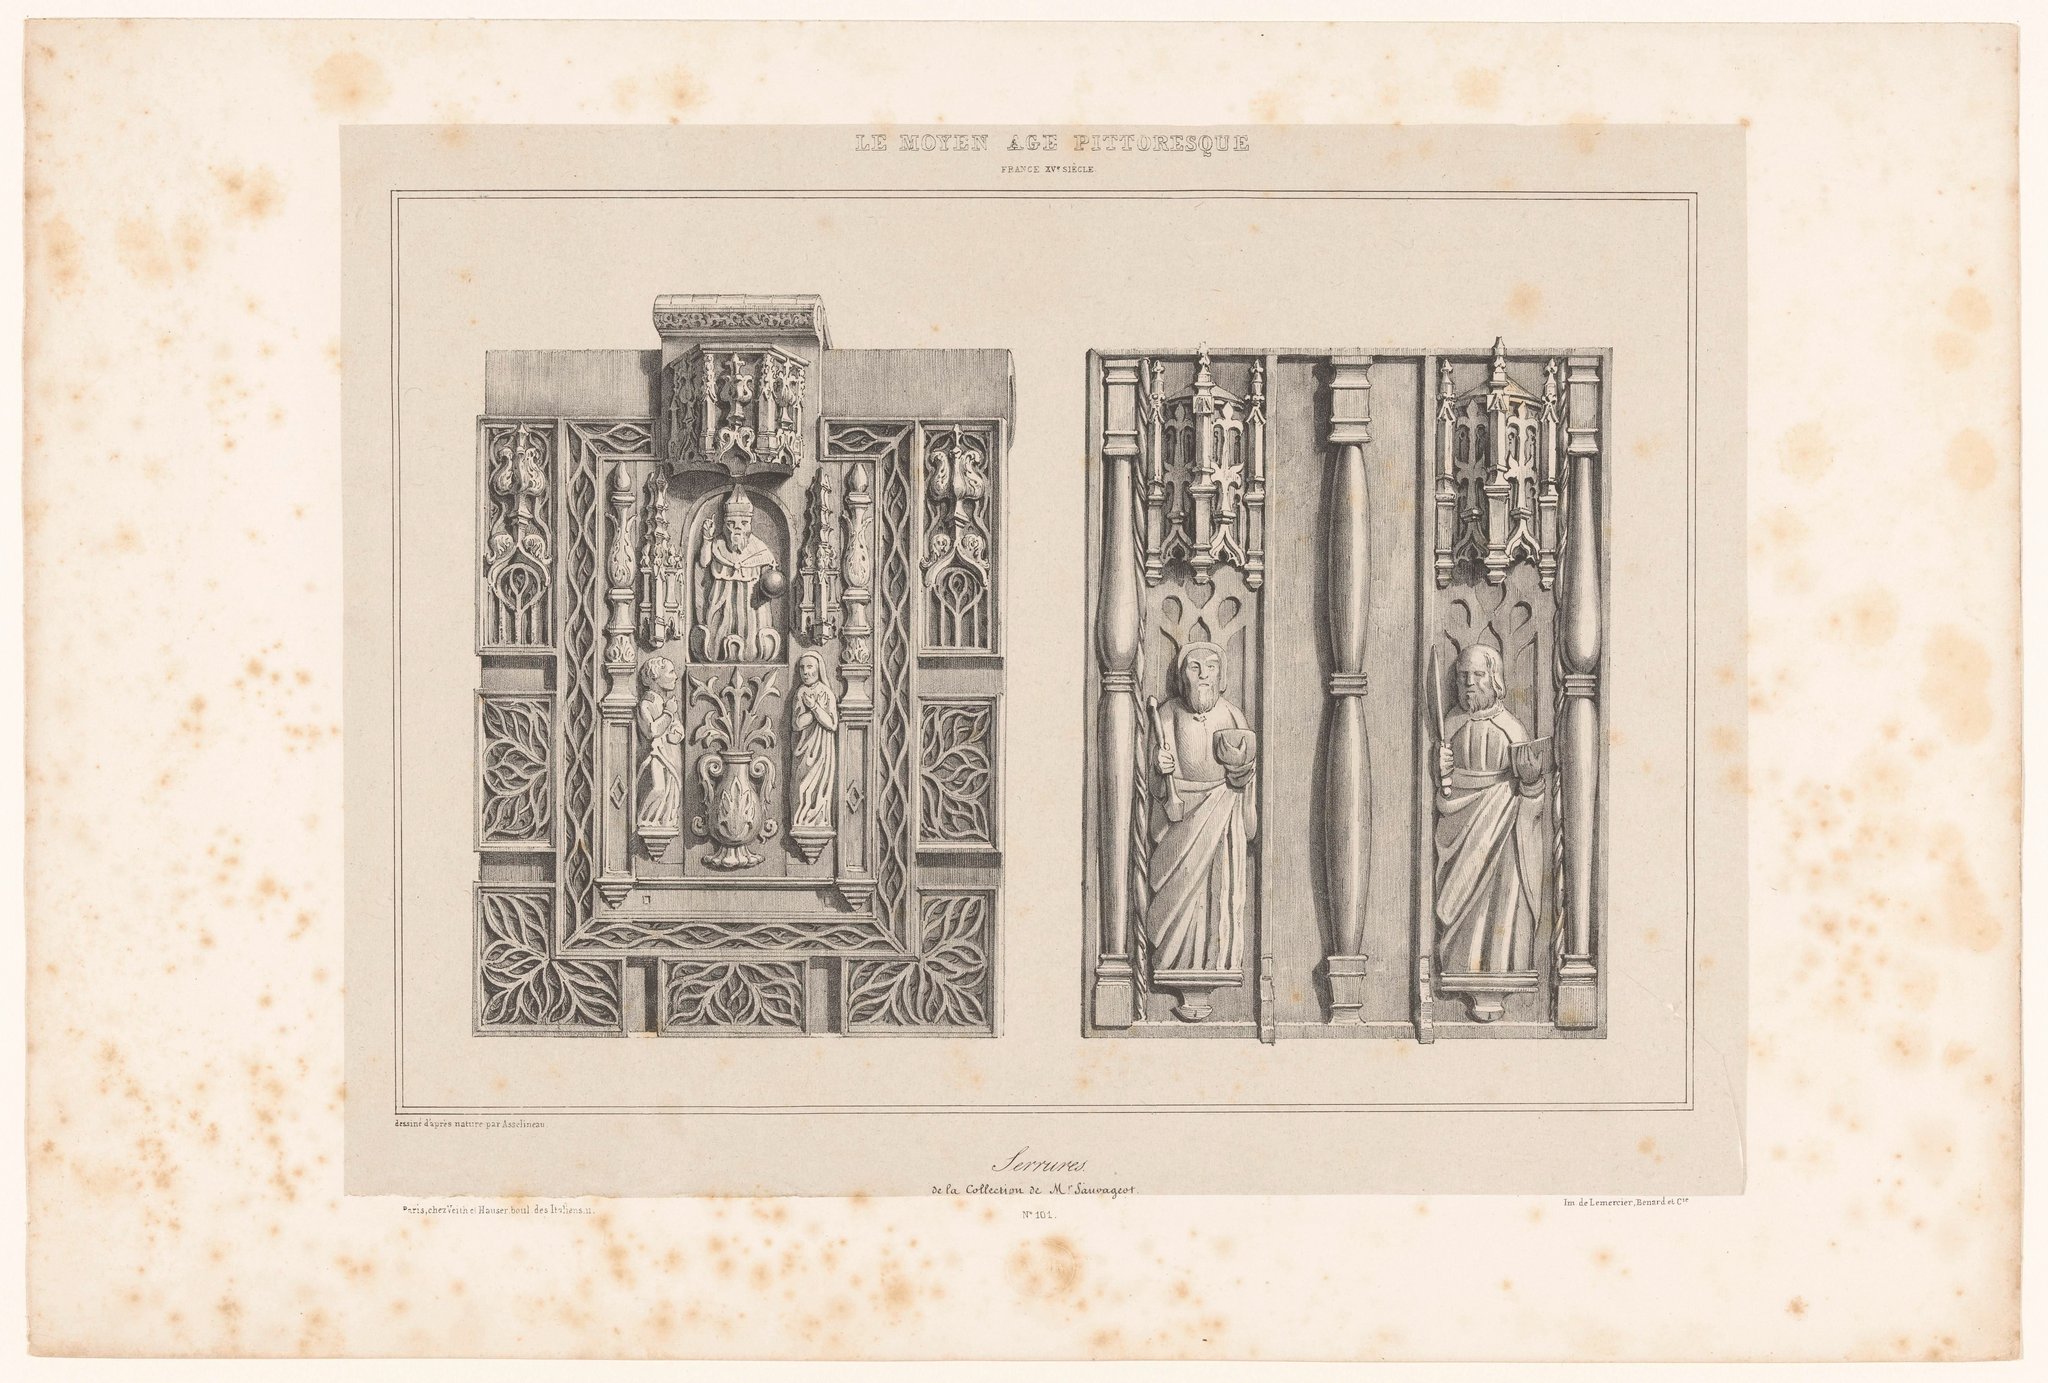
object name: print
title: Le Moyen Age pittoresque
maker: léon auguste asselineau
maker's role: print maker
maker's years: 1808-1889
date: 1837-1839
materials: paper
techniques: lithograph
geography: rouen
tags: lock ~ door, lock ~ furniture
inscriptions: check stamp: Lugt 4211, collector's mark: Lugt 2228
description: Afbeelding van twee vijftiende-eeuwse sloten met een voorstelling van Bijbelse figuren in reliëf uit de collectie van de Franse verzamelaar Charles Sauvageot (1781-1860).